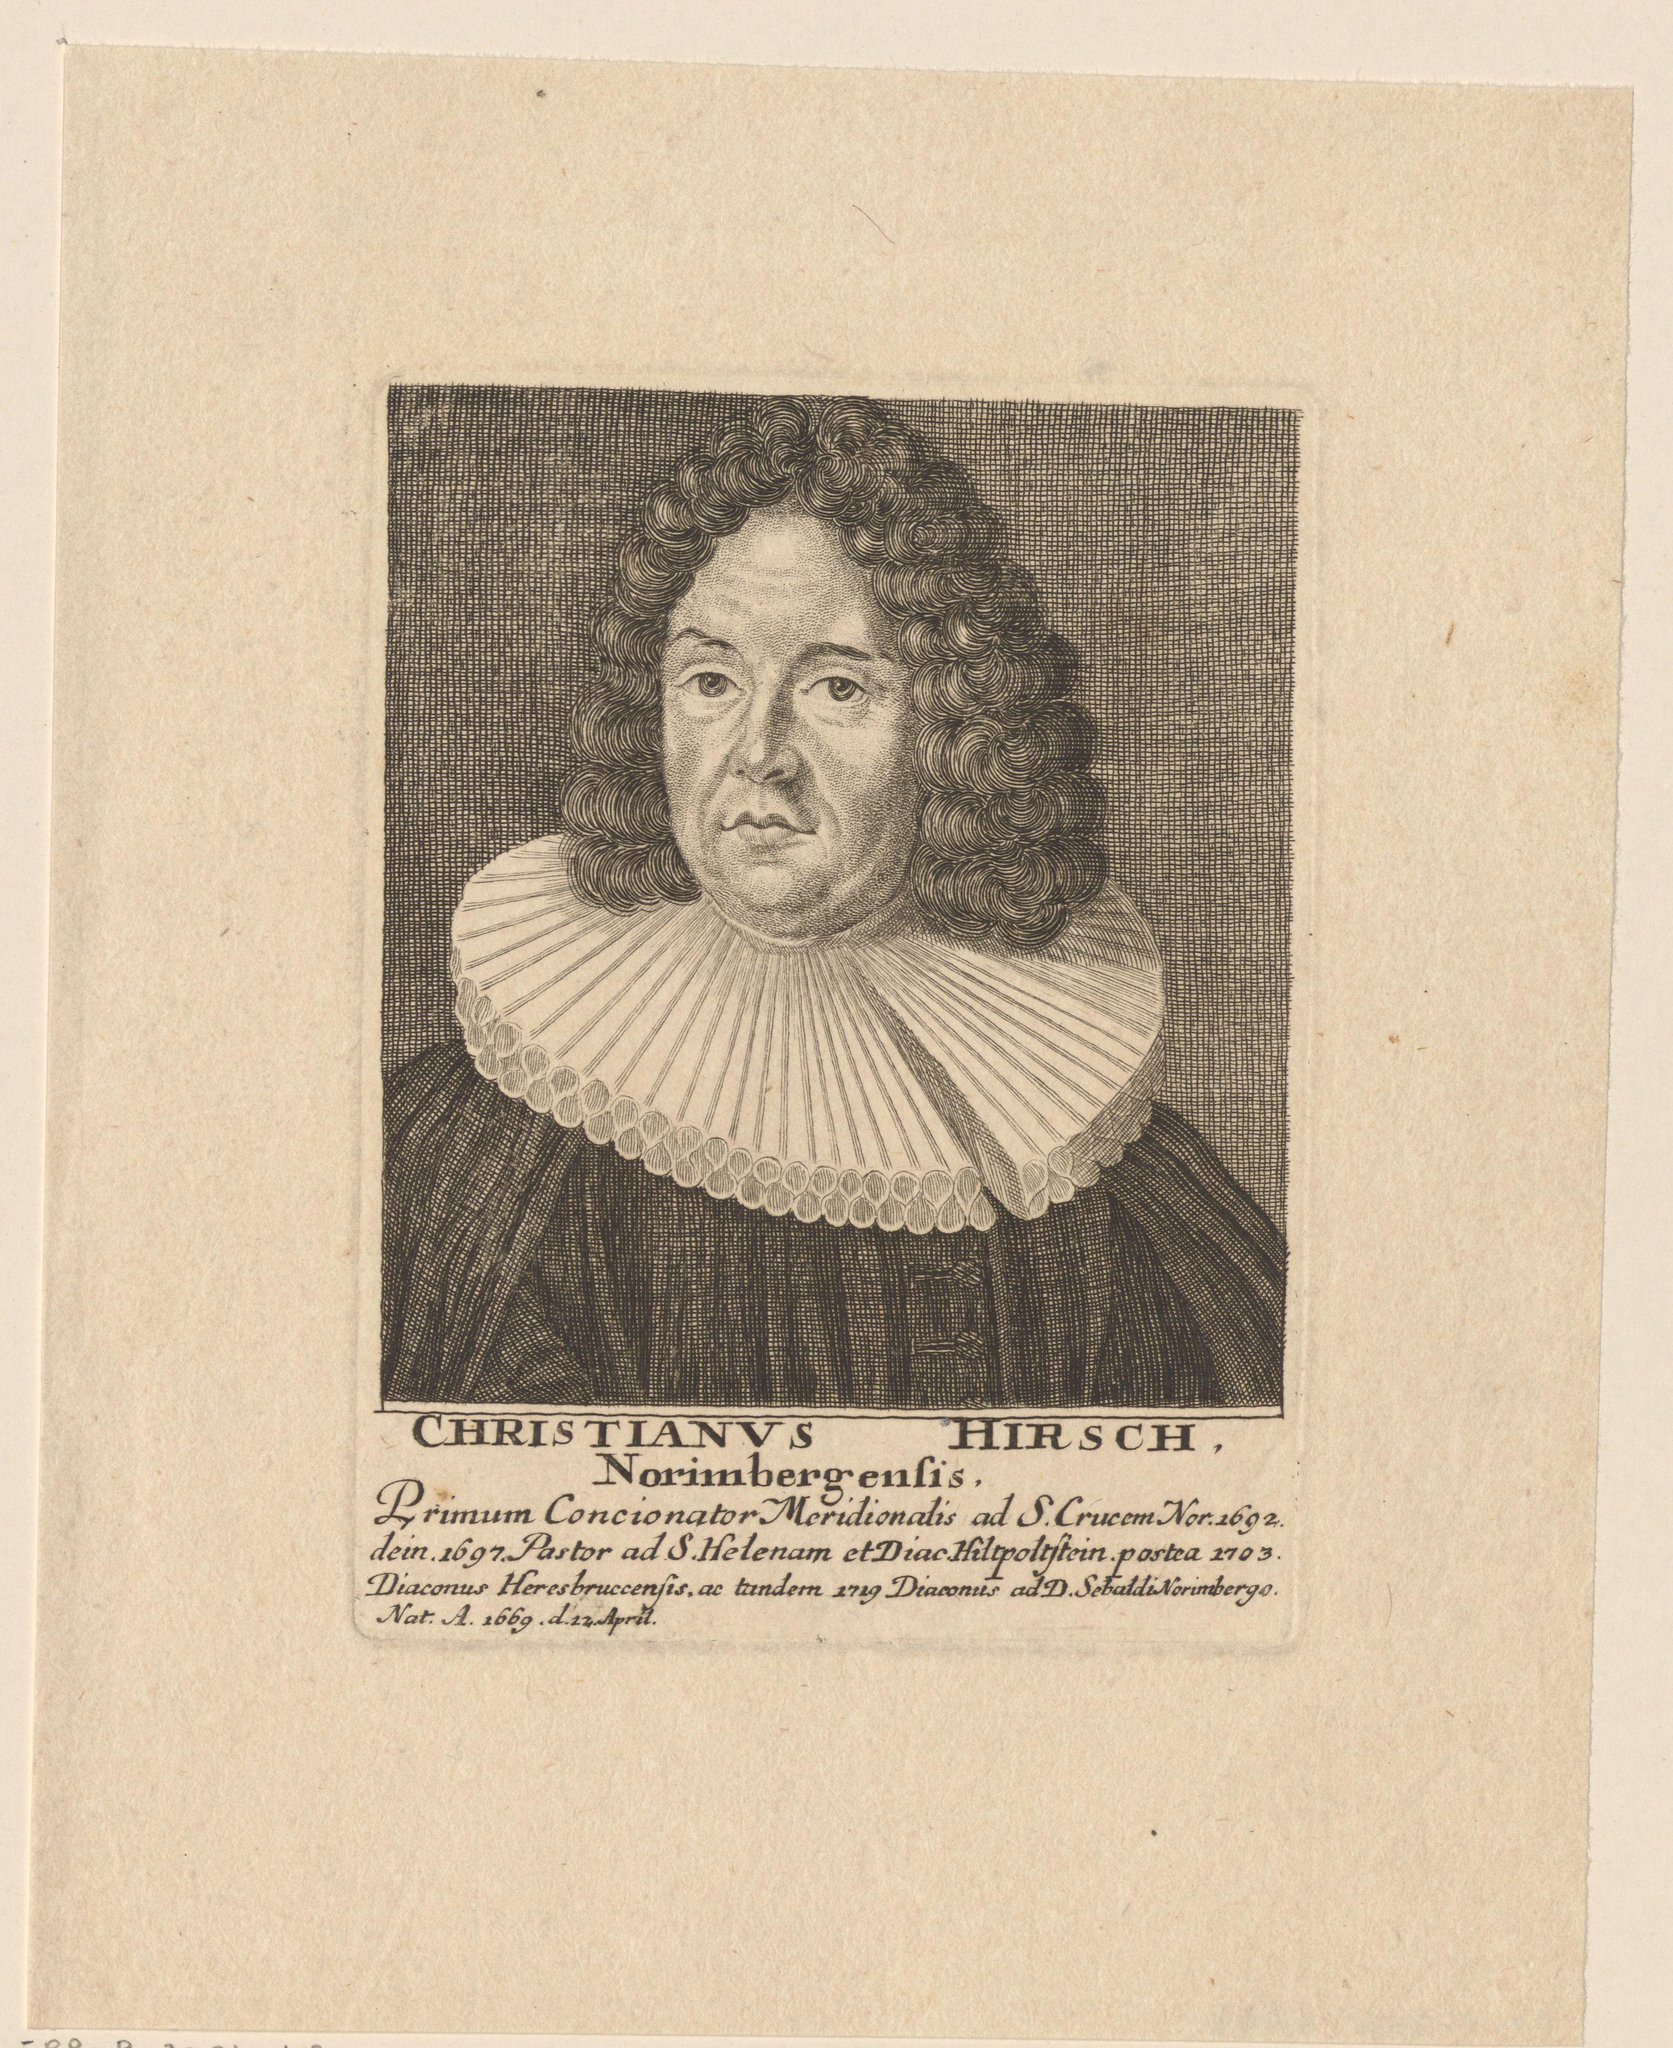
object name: print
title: Portret van Christian Hirsch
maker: Anonymous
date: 1700-1749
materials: paper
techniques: engraving, etching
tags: theologian, historical persons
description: Prent mogelijk uit: Roth-Scholtz, Friedrich. Icones virorum de Republica litteraria optime meritorum. Neurenberg en Altdorf: erven Johann Daniel Tauber, 1725, dl. 2.